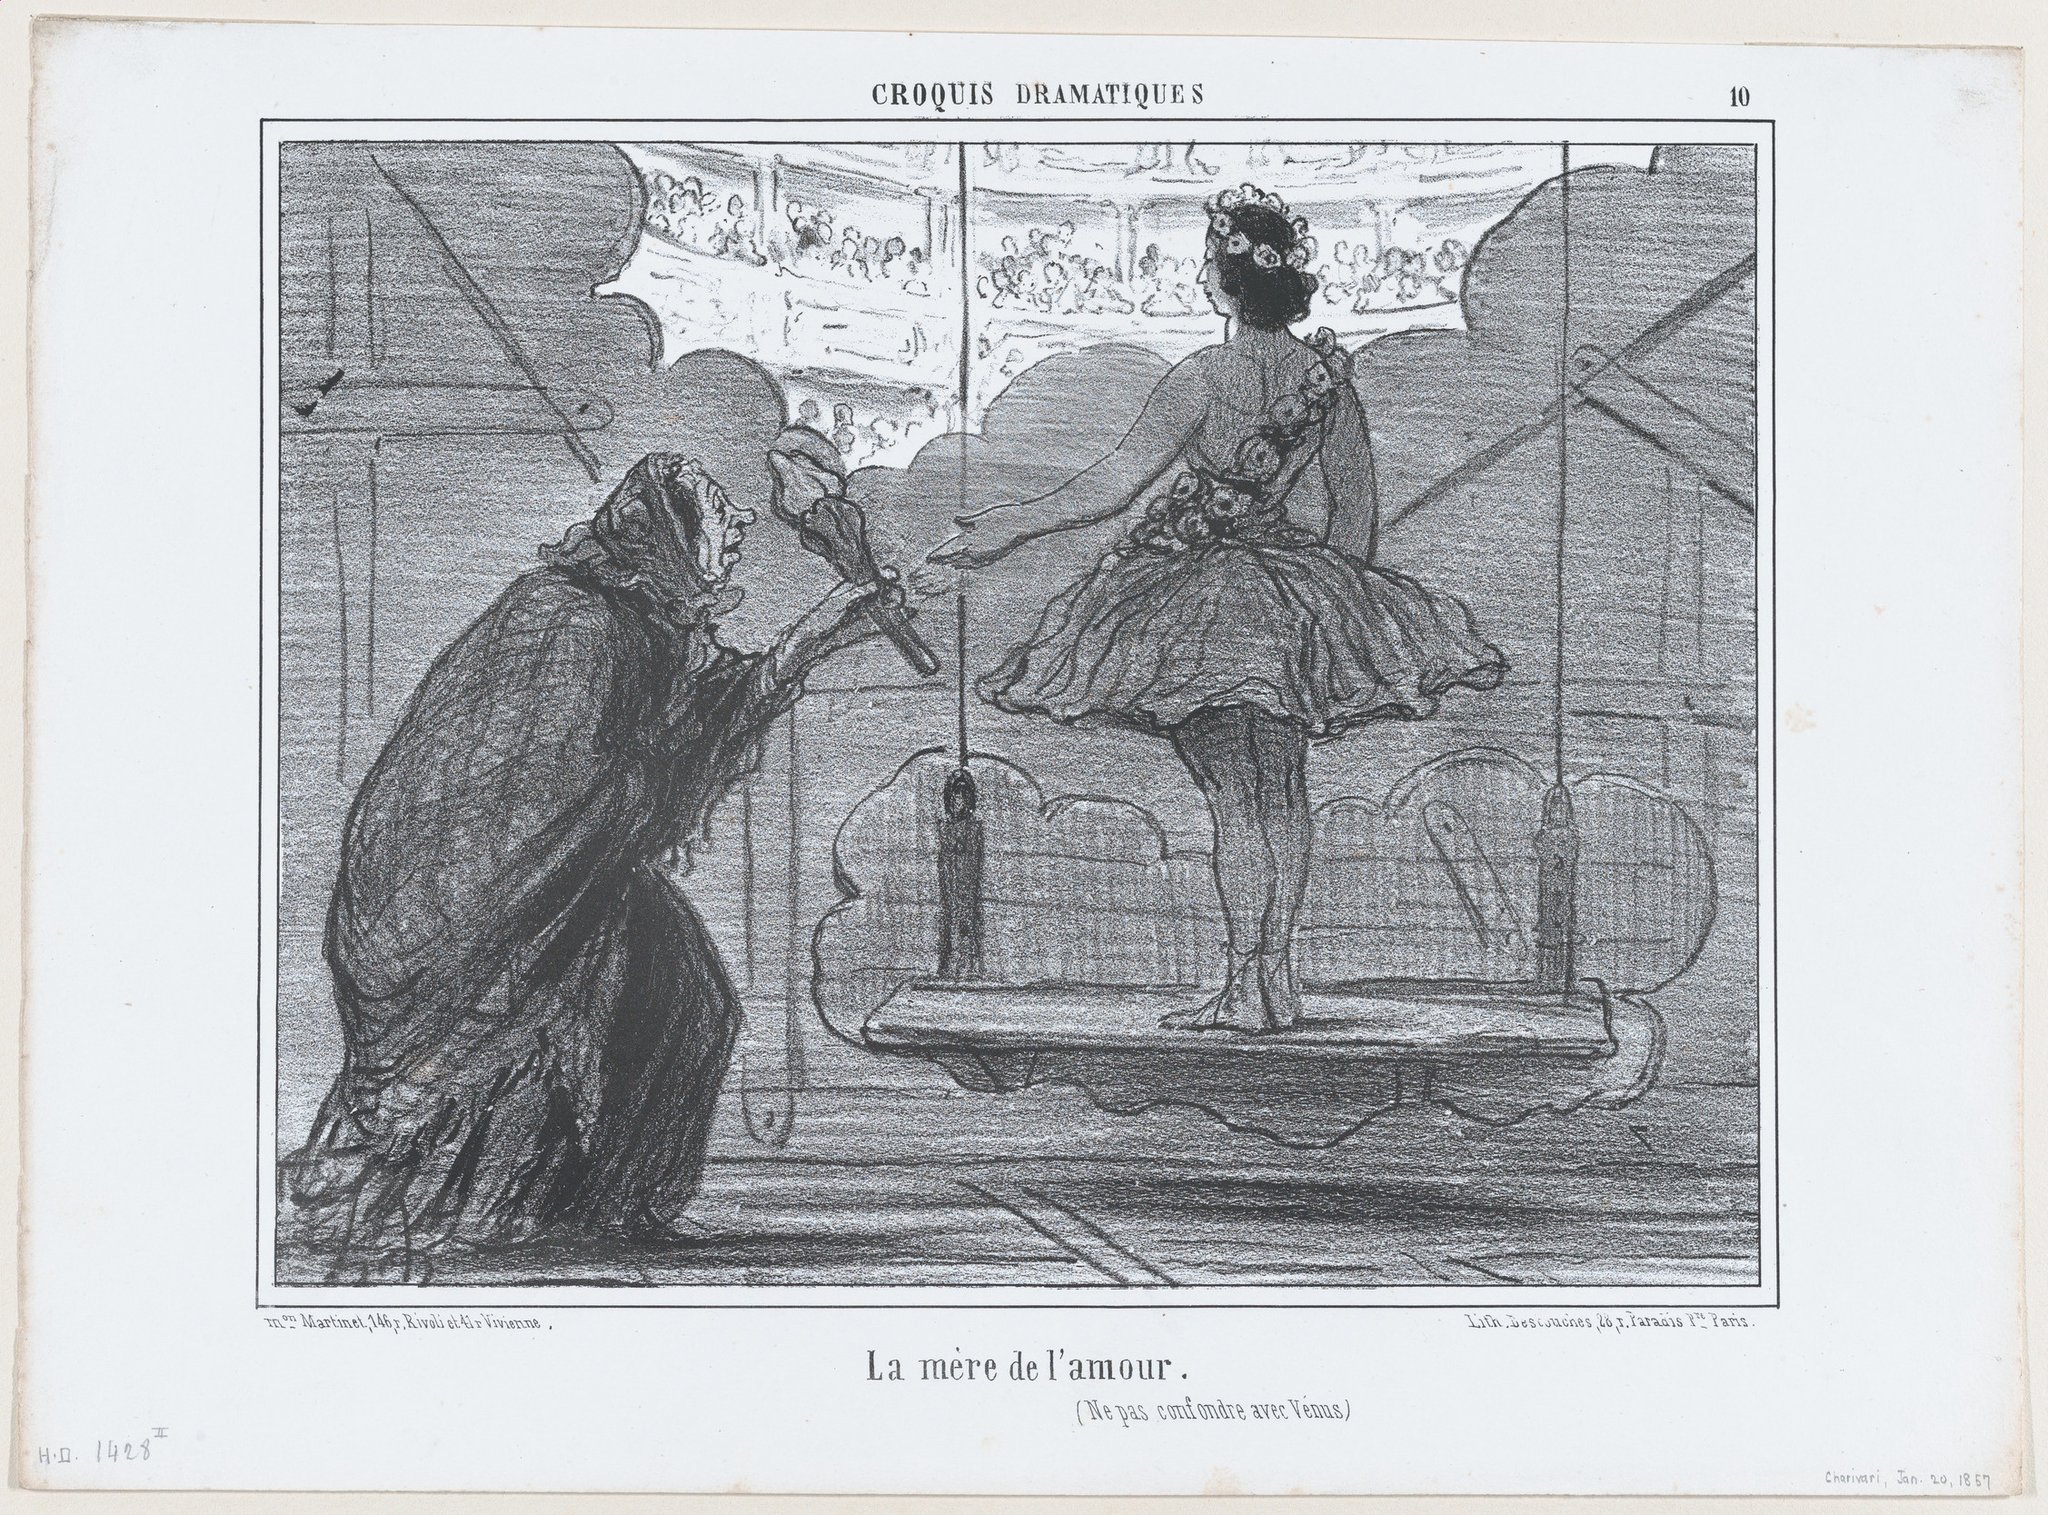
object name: print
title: Dire que dans mon temps, moi aussi..., from Croquis Dramatiques, published in Le Charivari, January 24, 1857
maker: honoré daumier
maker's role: artist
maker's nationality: french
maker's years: 1808-1879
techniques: lithograph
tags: women,spectators